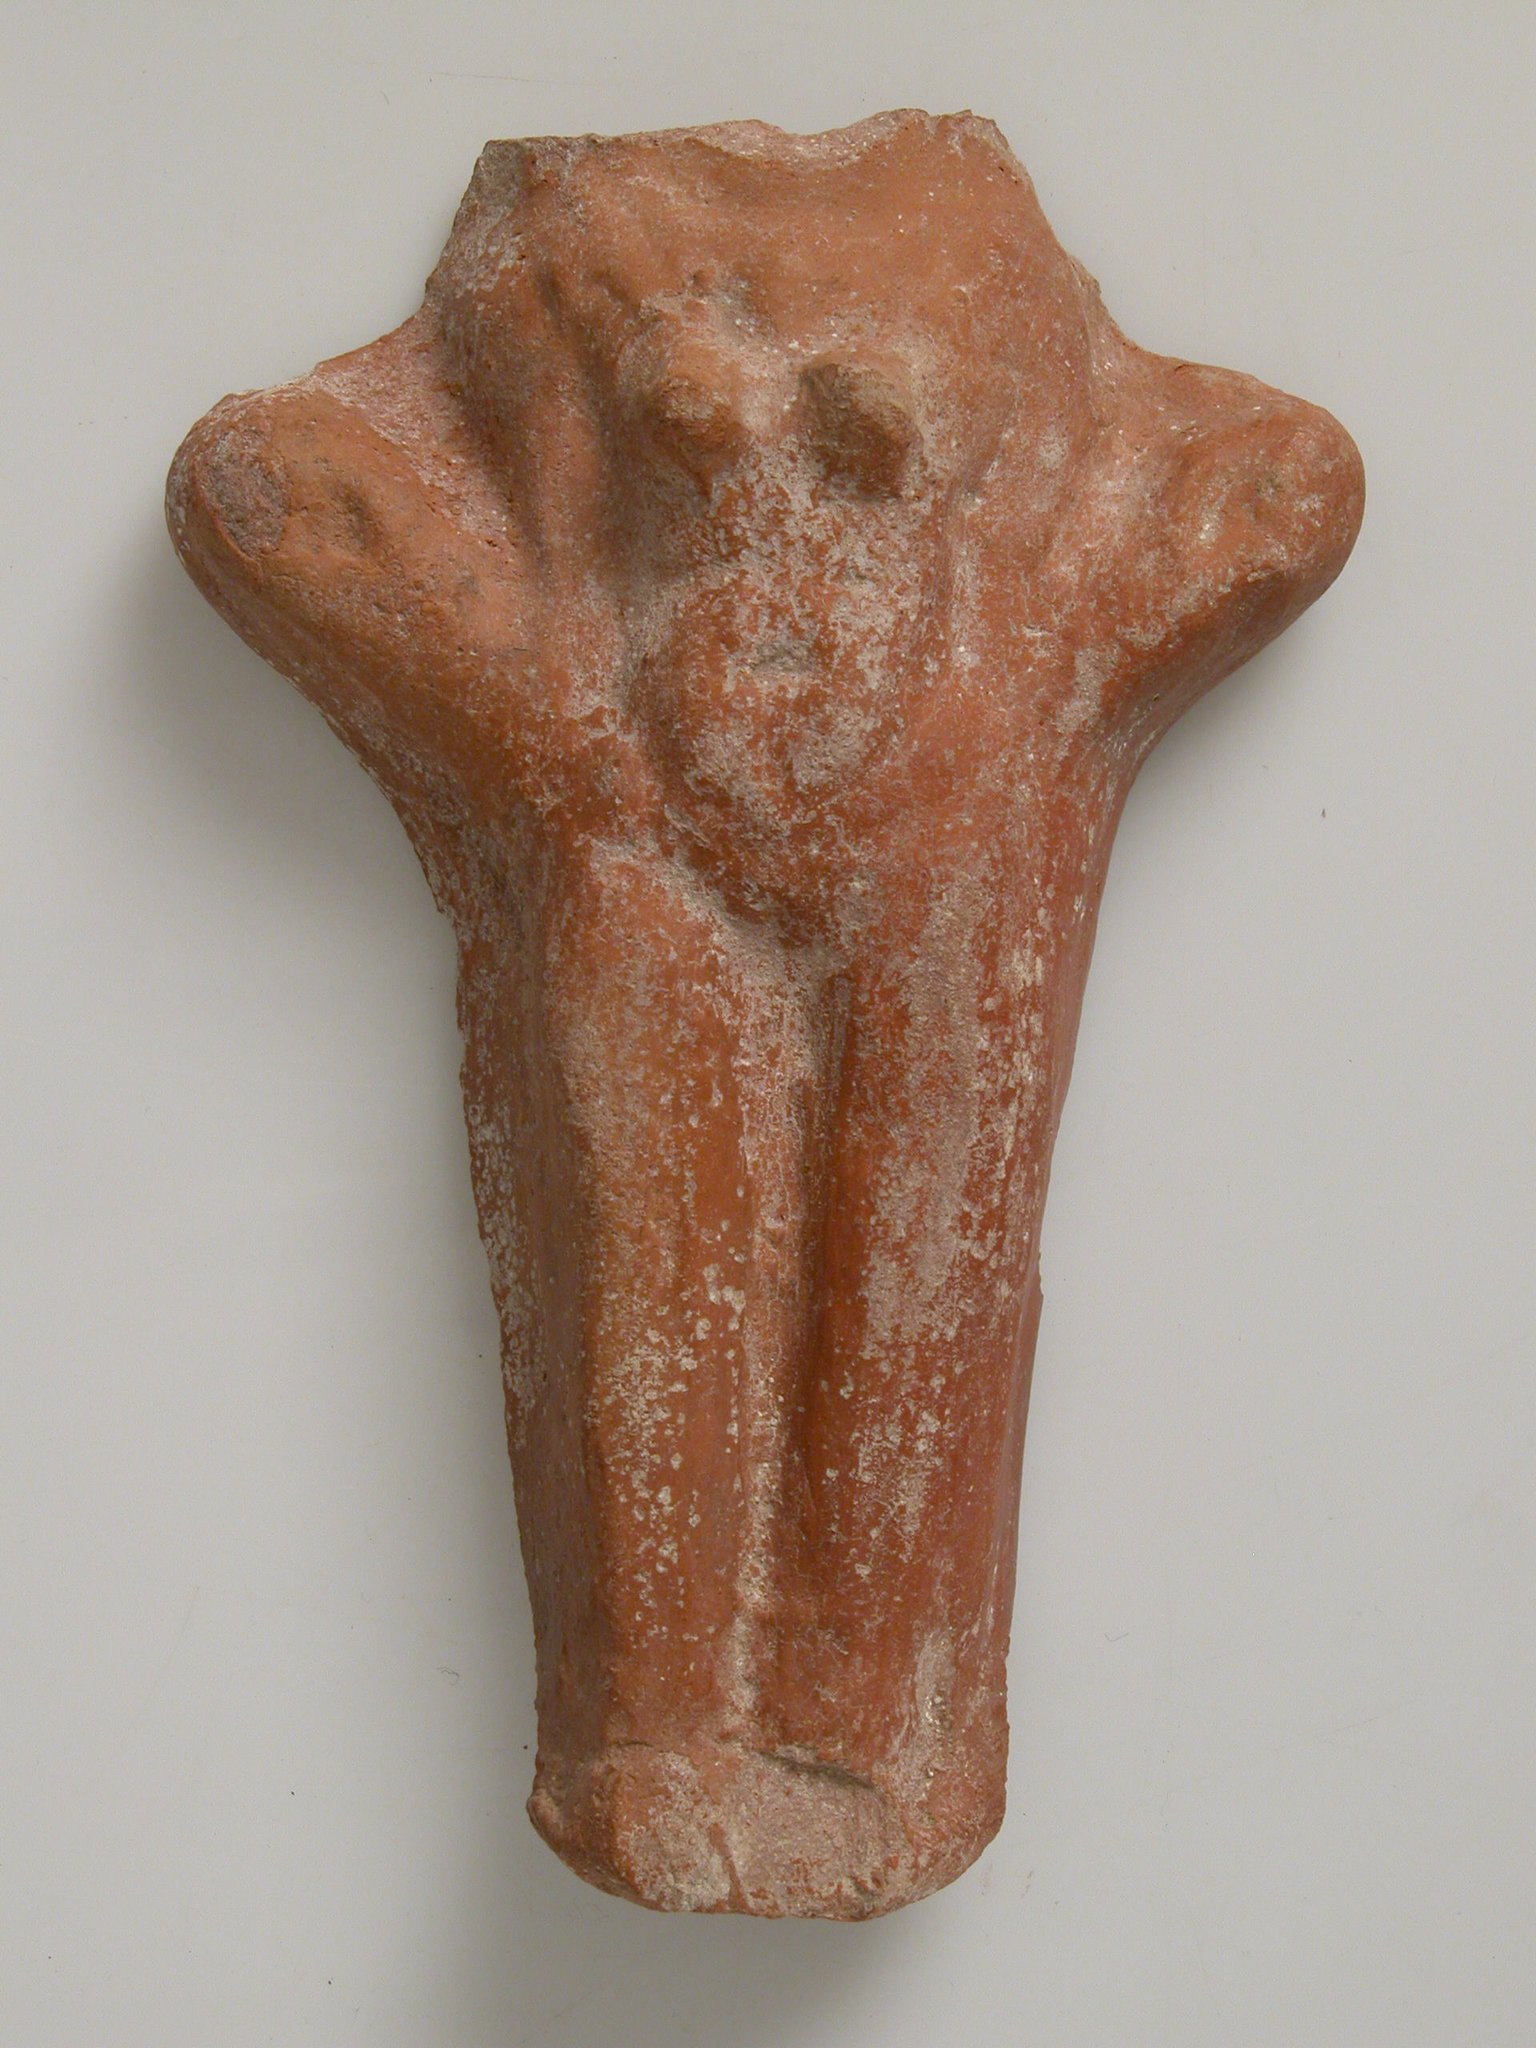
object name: statuette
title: Fragment of a Female Figure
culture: coptic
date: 301-700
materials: earthenware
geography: egypt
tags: women